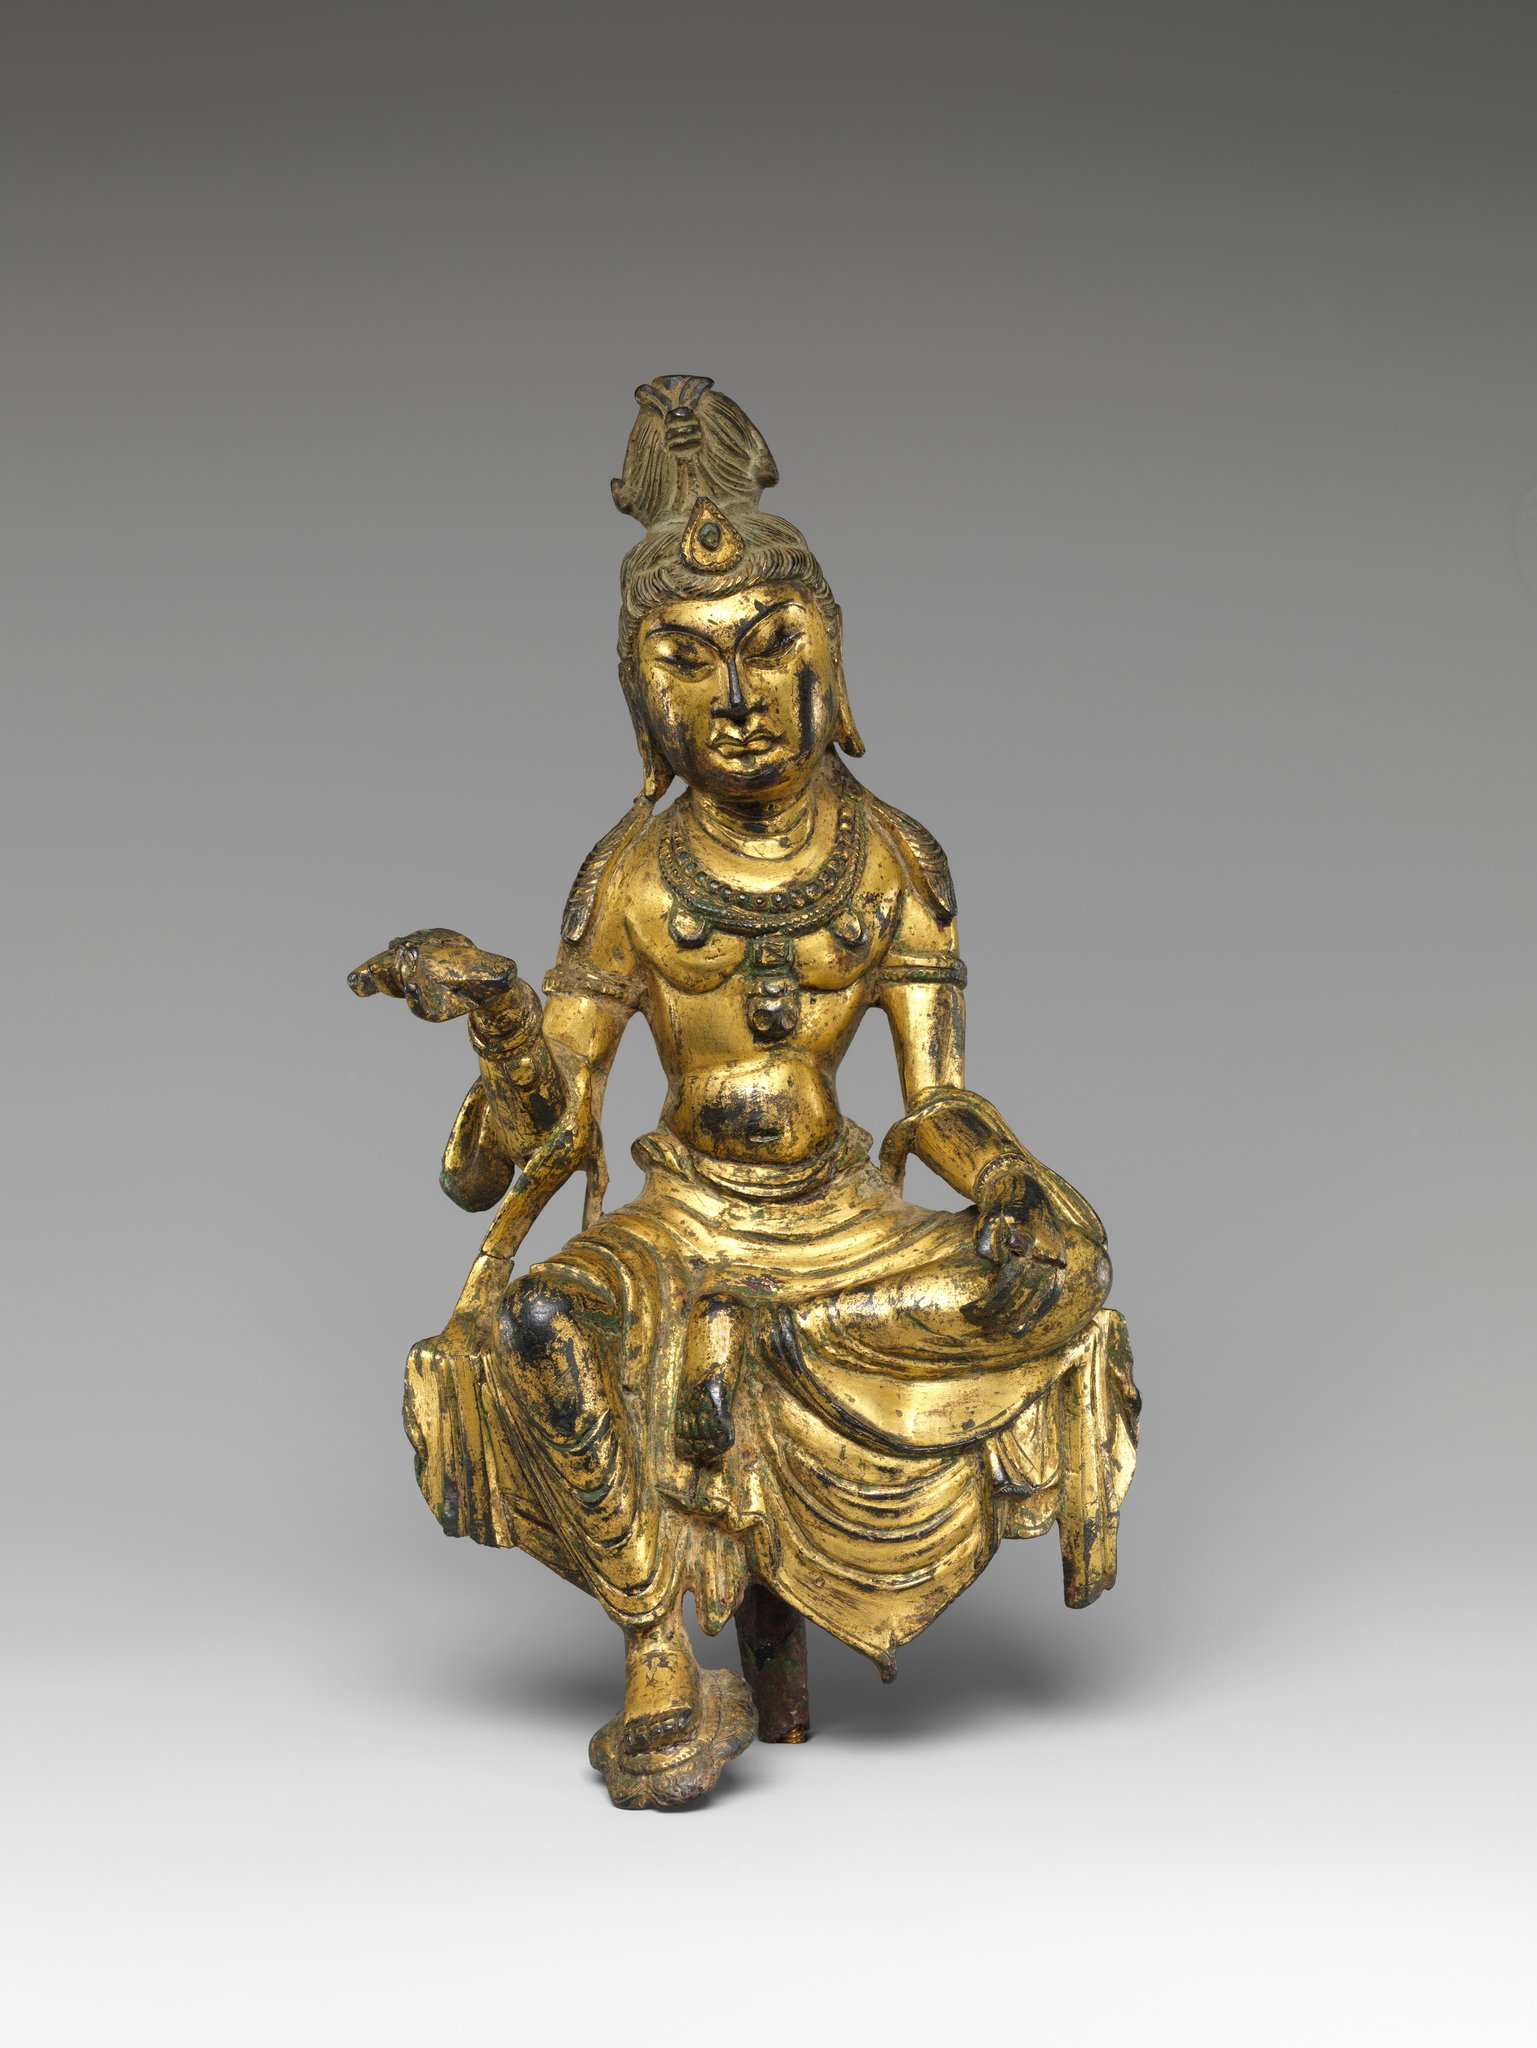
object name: figure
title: Seated bodhisattva, probably Manjushri (Wenshu)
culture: chinese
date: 701-900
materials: gilt bronze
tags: buddhism,bodhisattvas